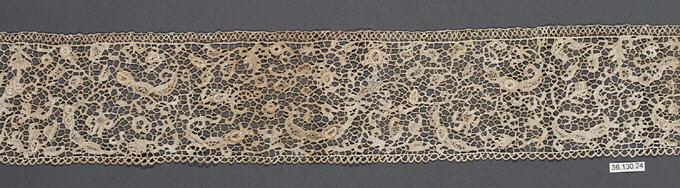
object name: border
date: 1601-1800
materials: lace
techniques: lace